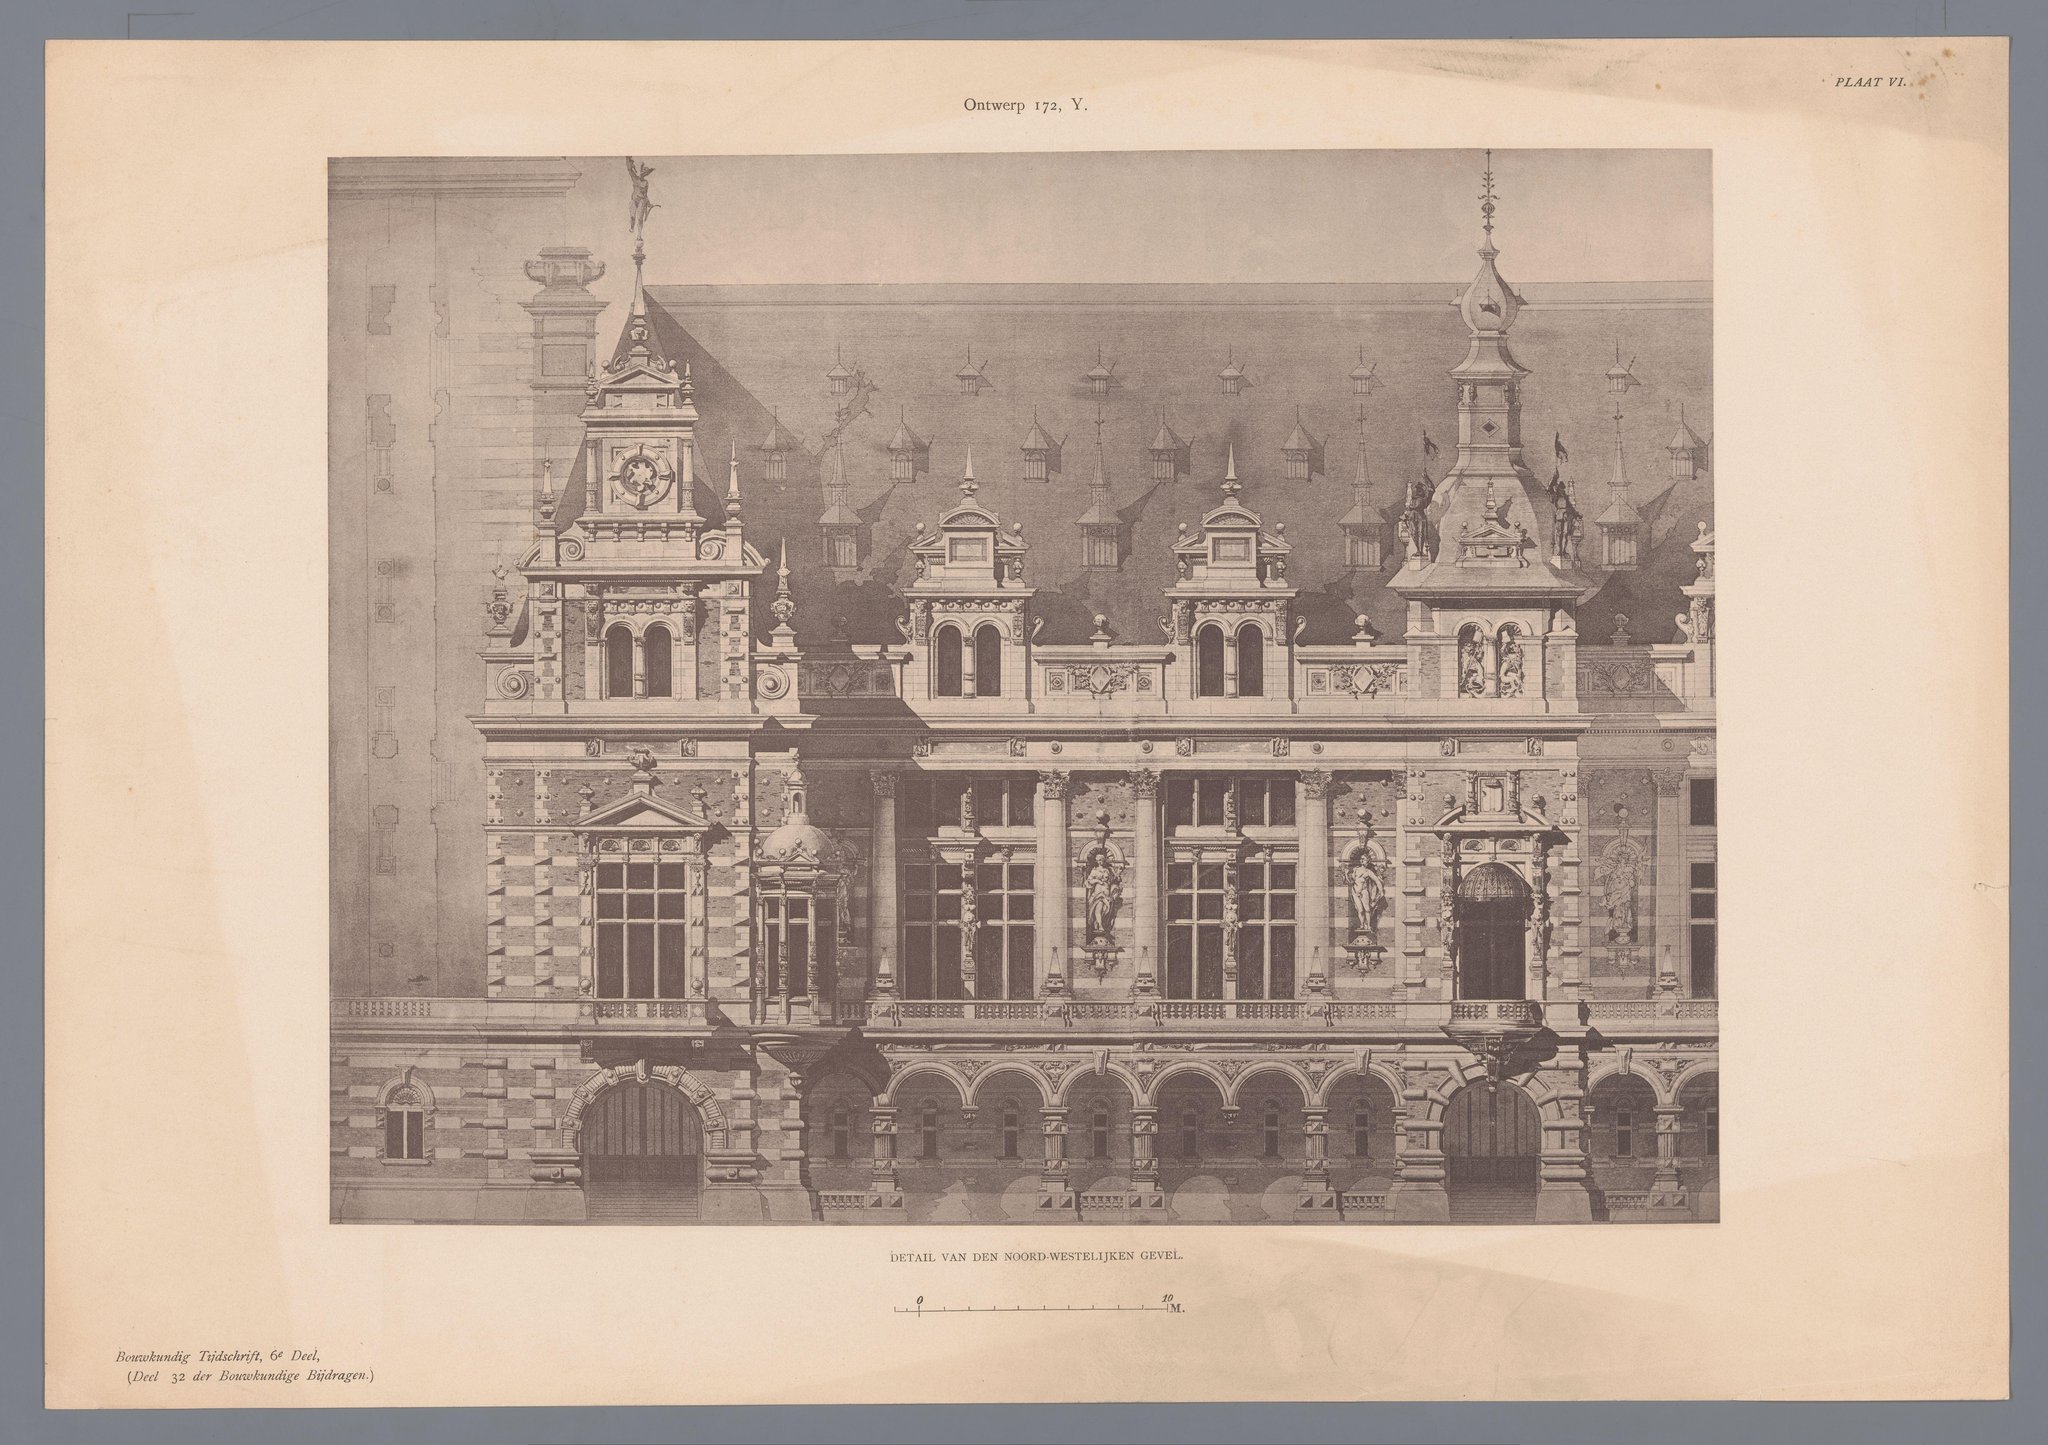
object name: book illustration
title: Ontwerp voor een nieuw beursgebouw in Amsterdam: geveldetail van ontwerp 172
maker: Anonymous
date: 1886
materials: paper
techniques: photograph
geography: amsterdam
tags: market-hall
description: Prent uit: Bouwkundig tijdschrift 6, deel 32 der bouwkundige bijdragen (1886), pl. 6.